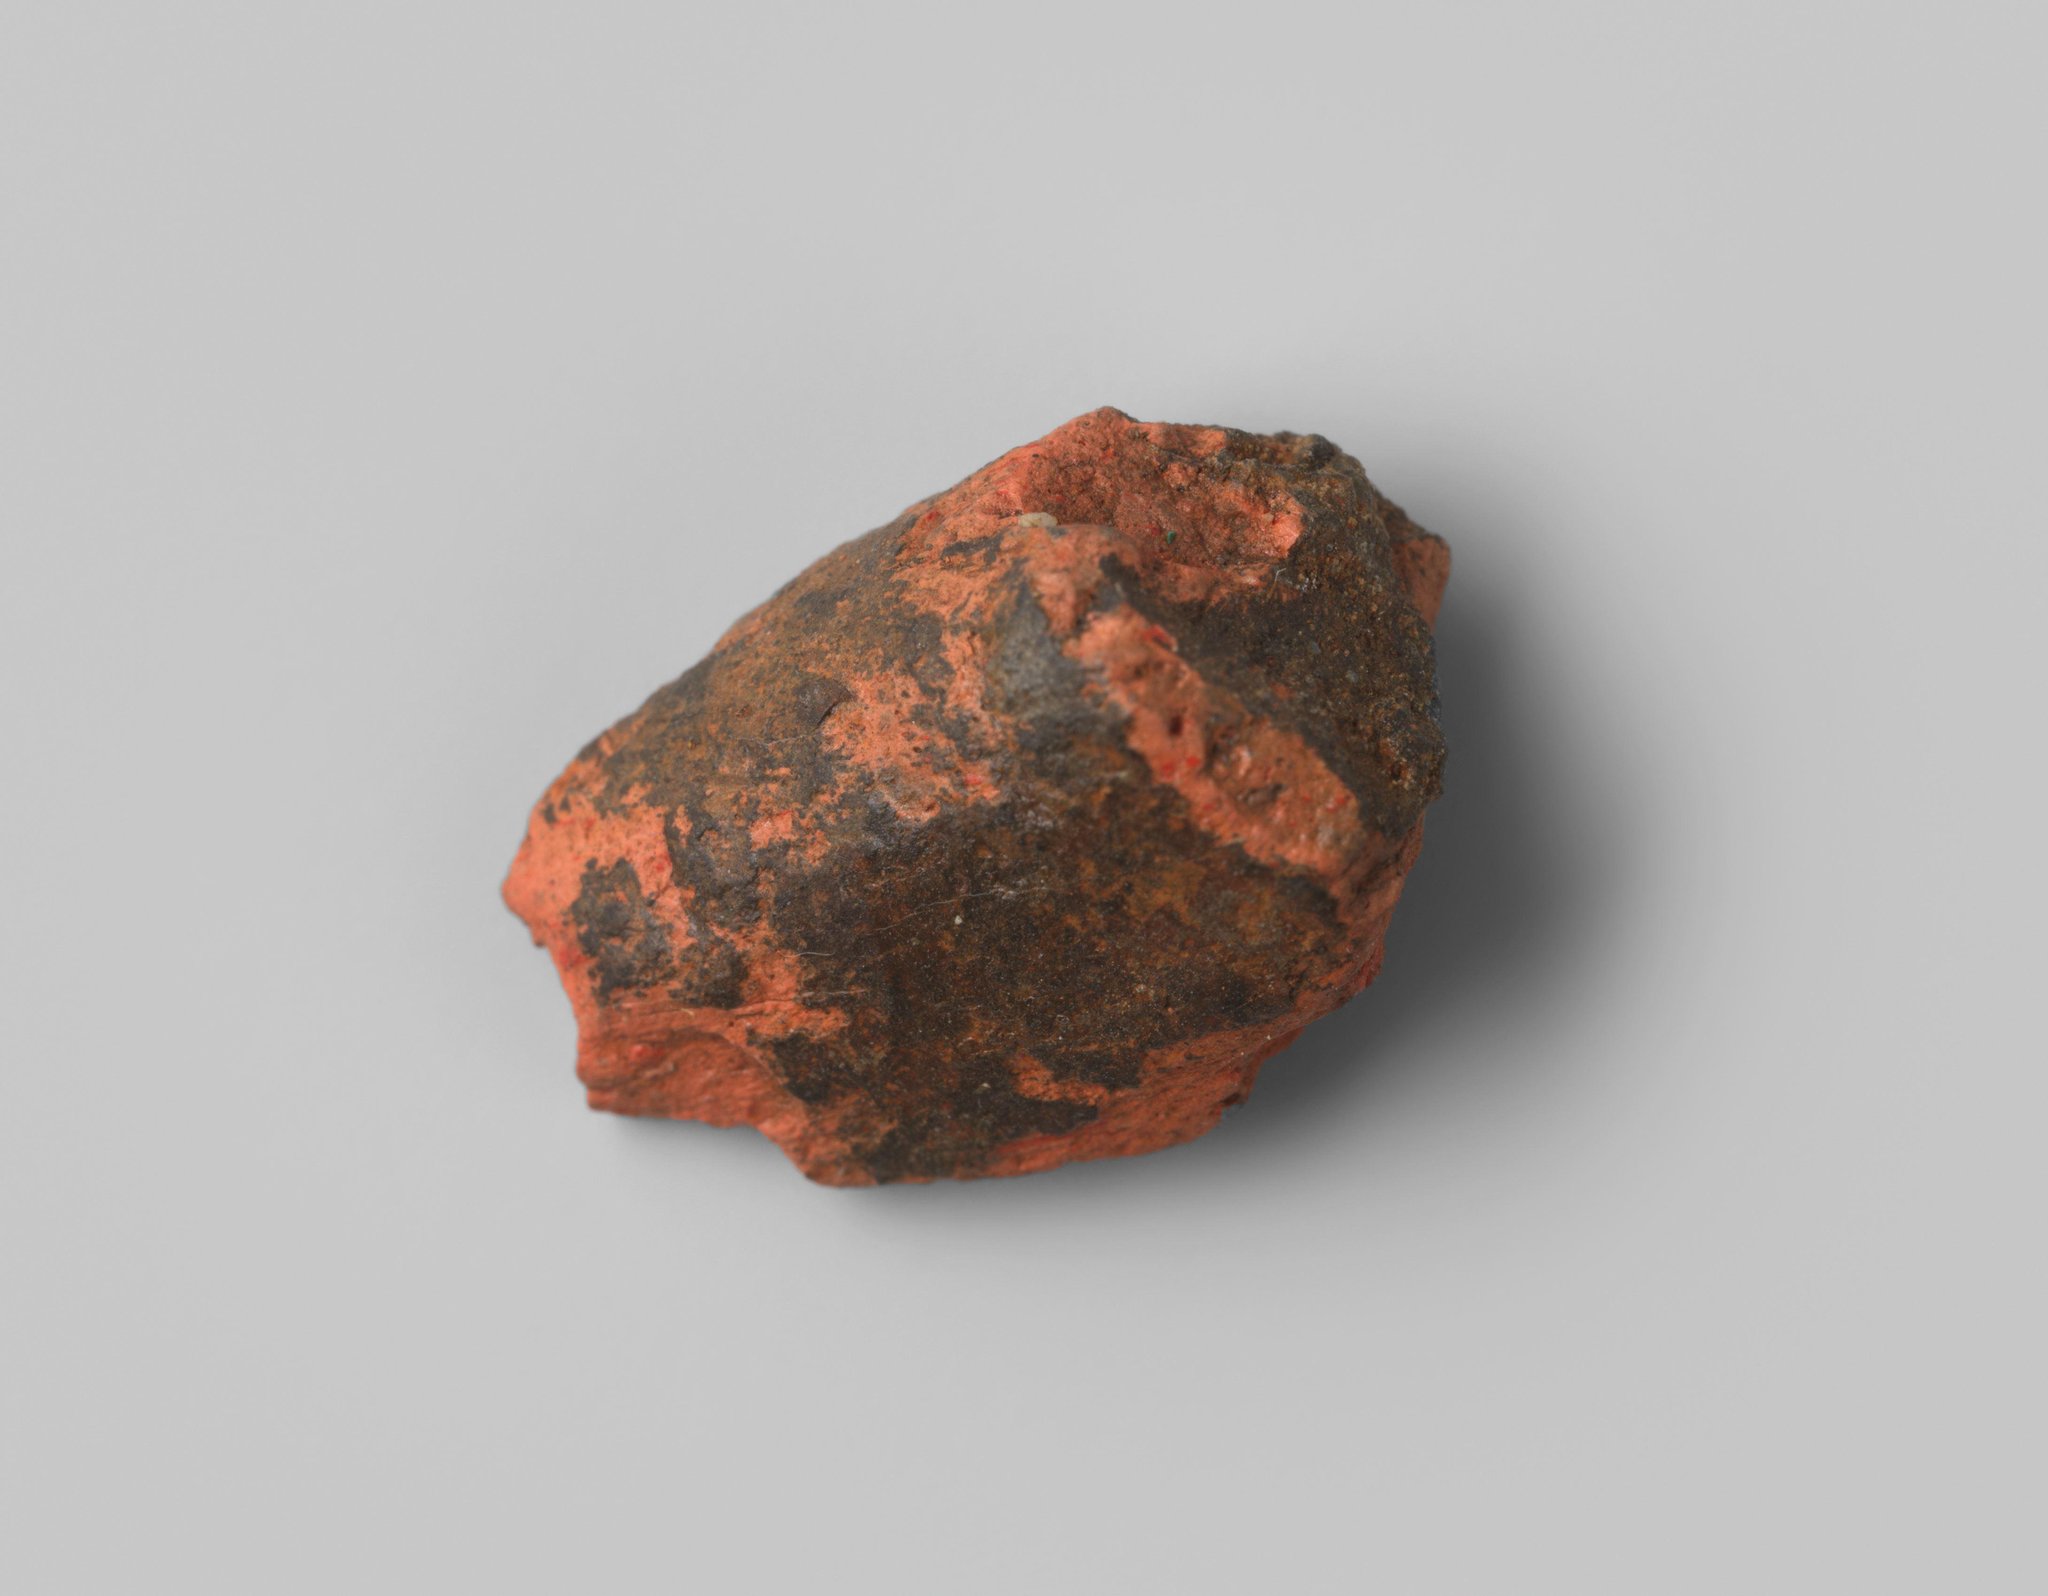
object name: sealing wax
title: Fragment zegellak uit het wrak van de Oost-Indiëvaarder Hollandia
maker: Anonymous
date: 1700-1743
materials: wax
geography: netherlands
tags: verenigde oostindische compagnie, hollandia (schip), annet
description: Marking and proving, sealing wax, red; fragm, broken, eroded.